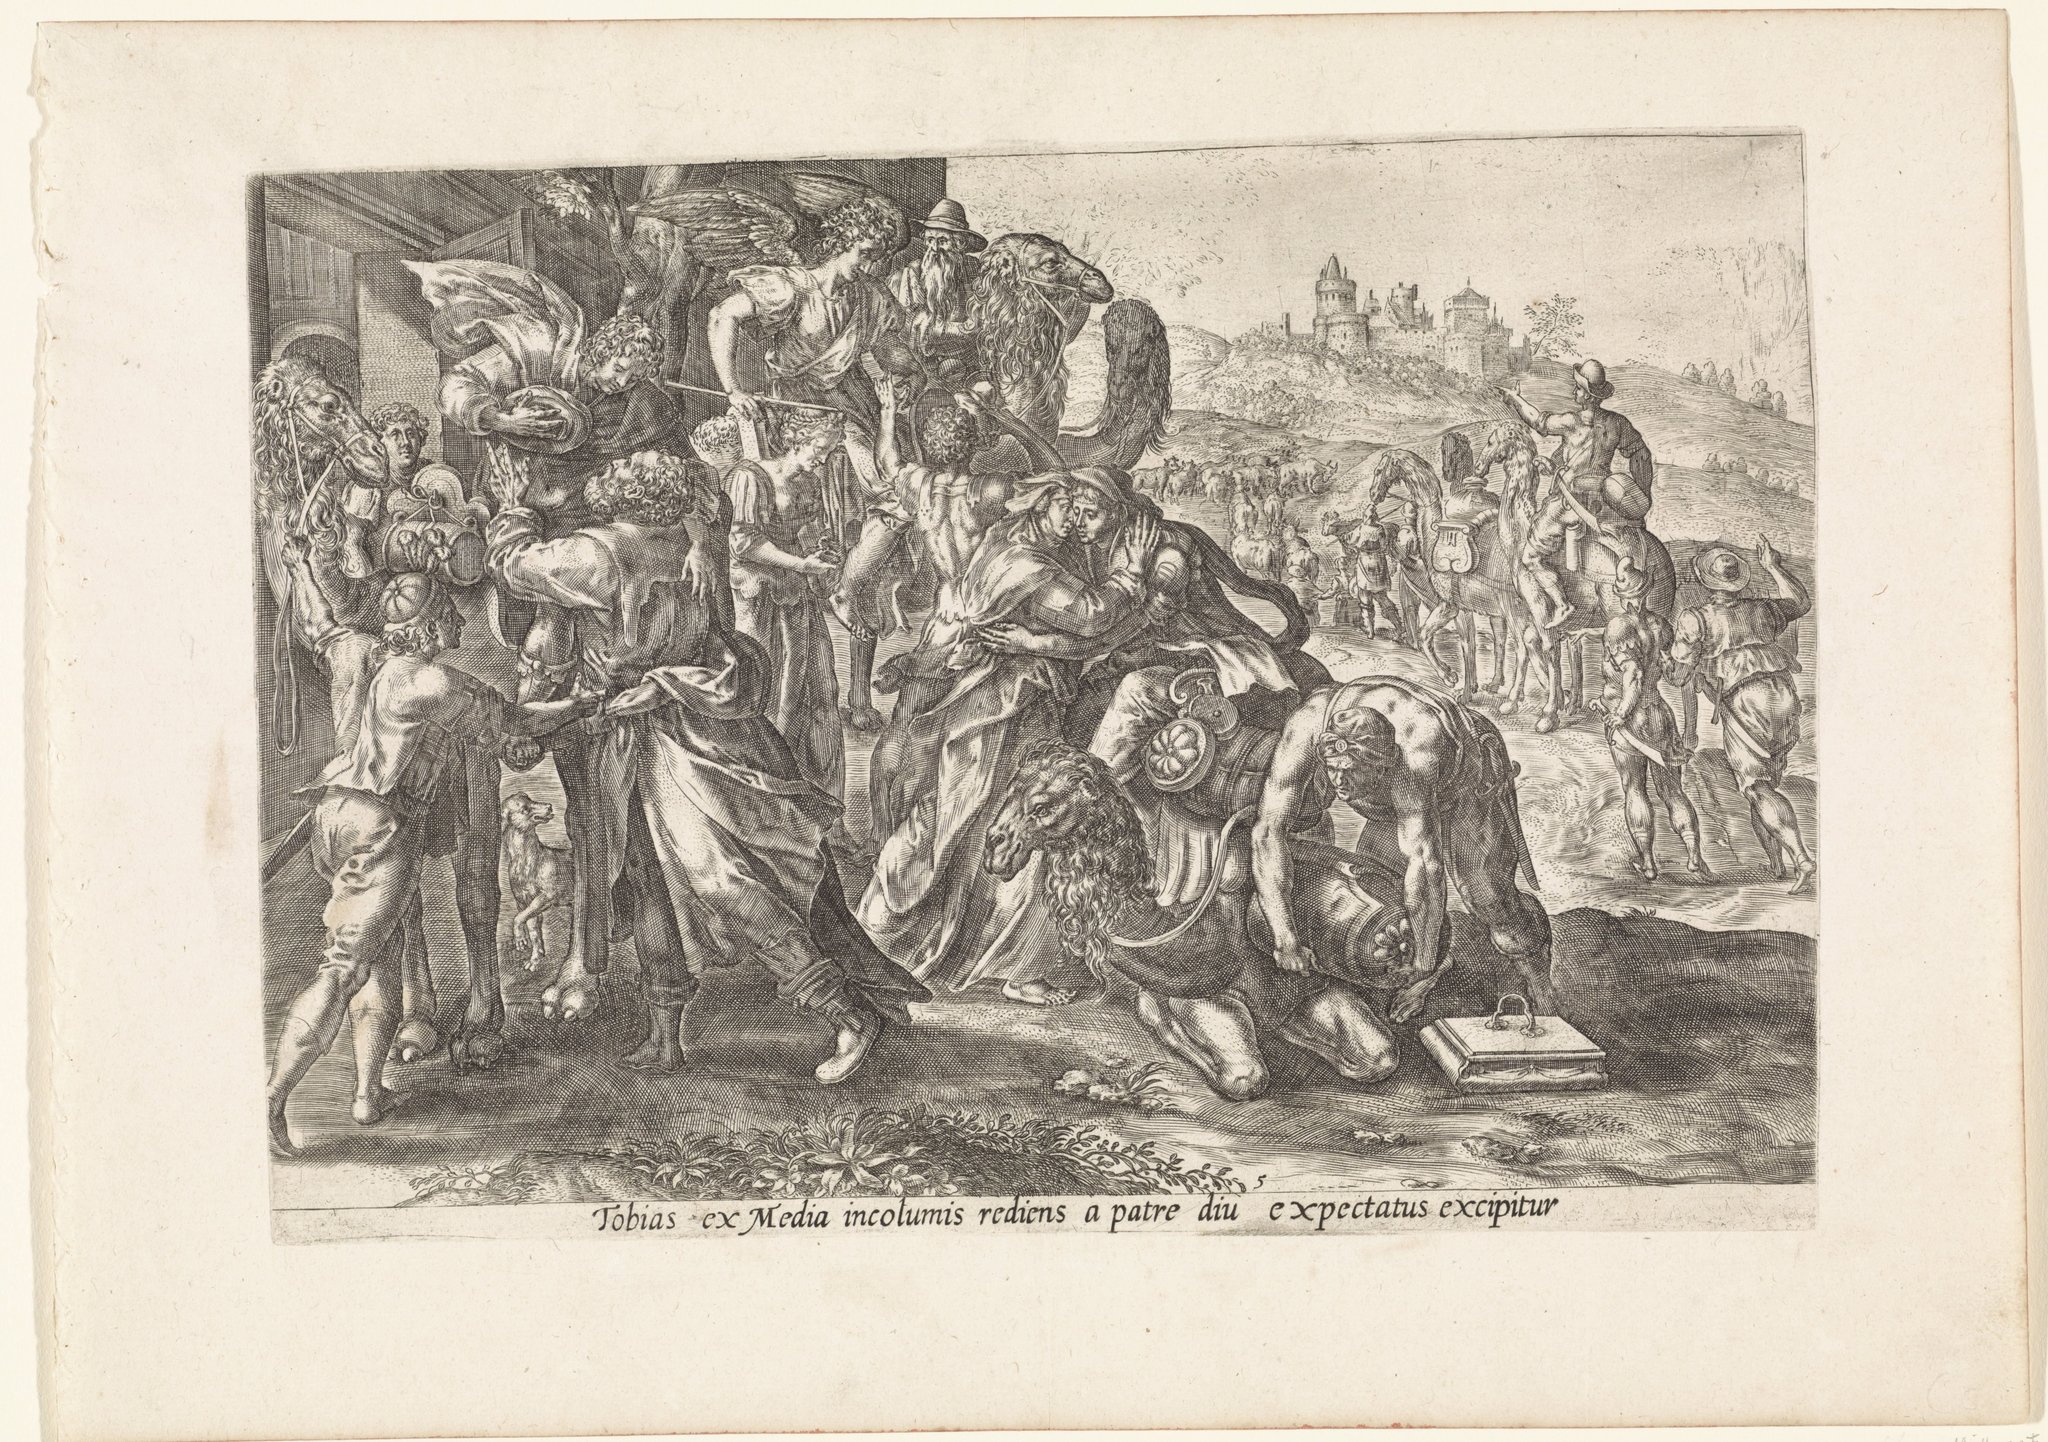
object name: print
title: Geschiedenis van Tobias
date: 1585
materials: paper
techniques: engraving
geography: antwerp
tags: the leave-taking ~ tobias' return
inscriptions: collector's mark: Lugt 2228, collector's mark: Lugt 2760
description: Prent gebruikt in: Thesaurus sacrarum historiaru[m] veteris (et novi) testame[n]ti, elega[n]tissimis imaginibus expressu[m] excelle[n]tissimoru[m] in hac arte viroru[m] opera : nu[n]c primu[m] in luce[m] editus. Antwerpen: Gerard de Jode, 1585.